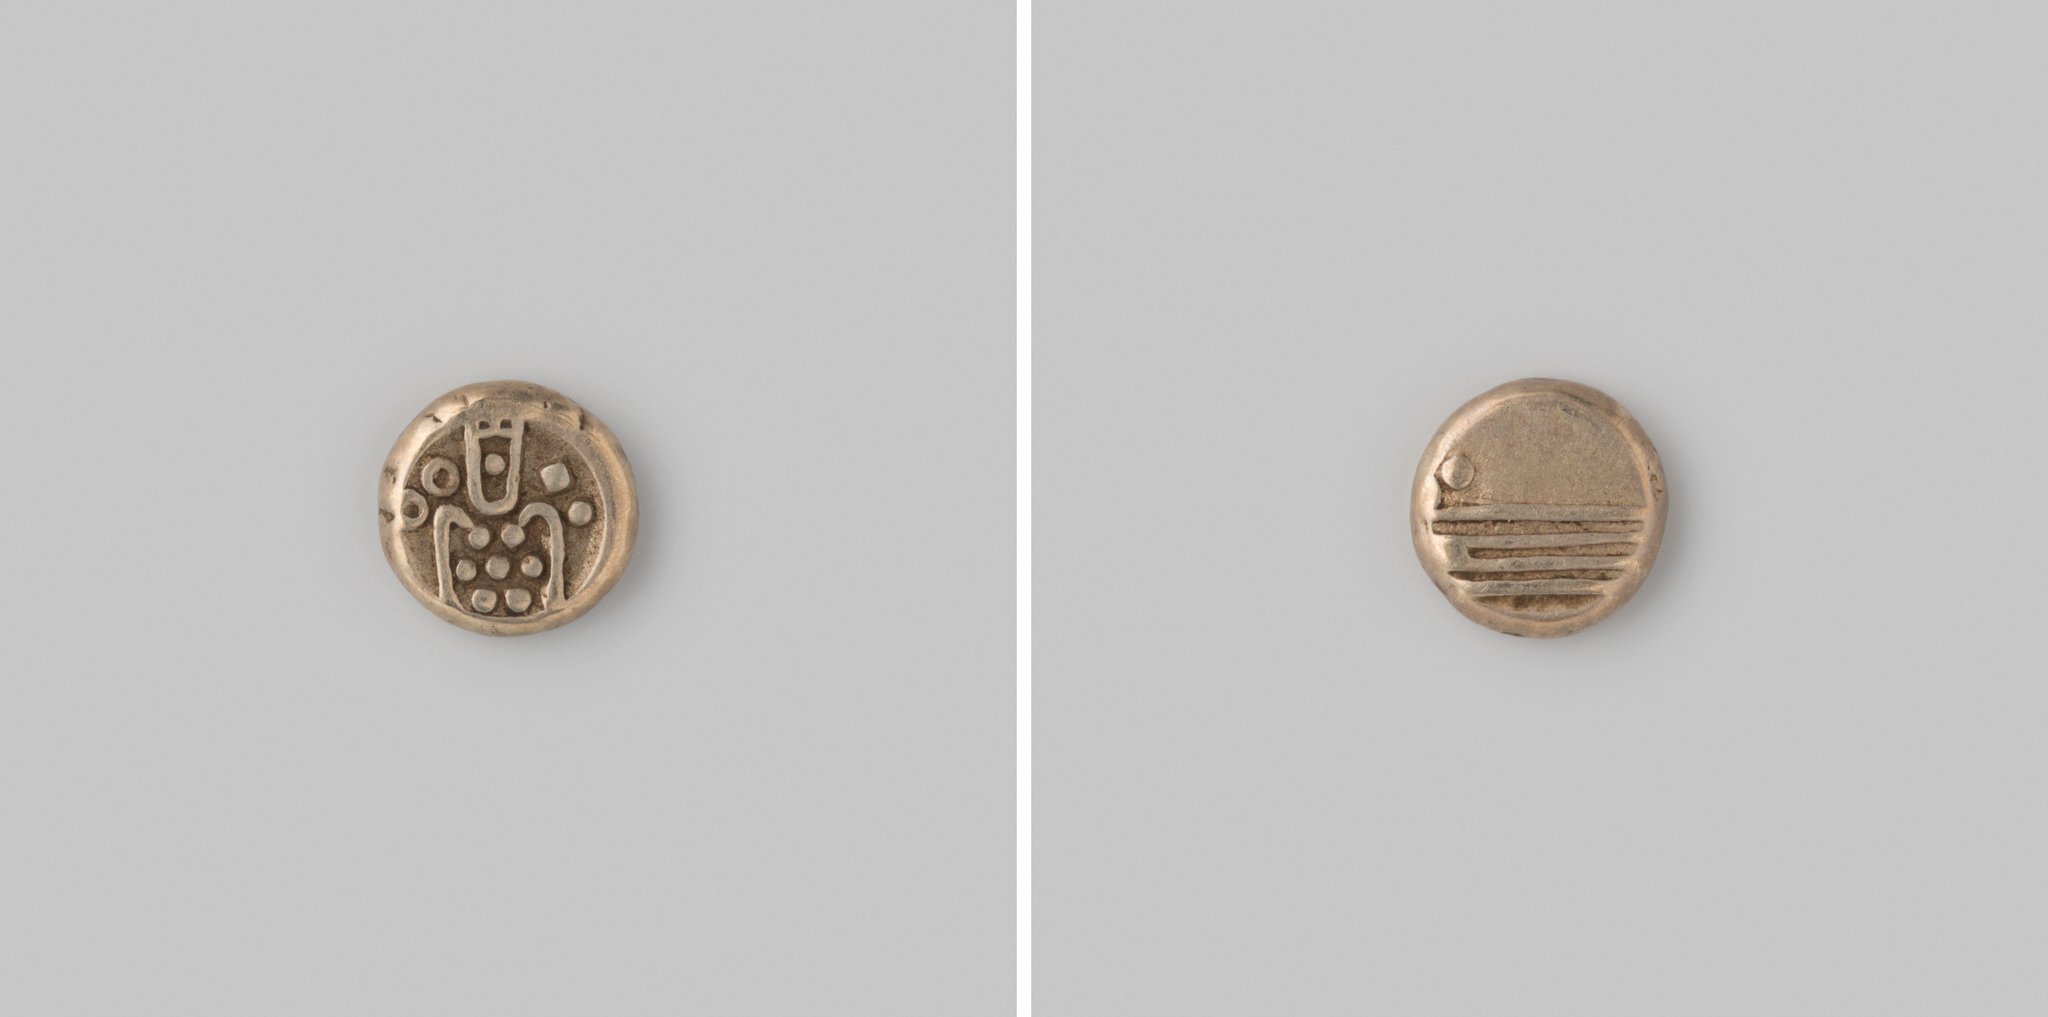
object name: coin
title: Fanam van de raja's van Coorg [?] in India,1687-1834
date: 1687-1834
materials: silver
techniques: striking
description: goud-zilveren munt. Voorzijde: vira raya-beeltenis. Keerzijde: ondetermineerbare lettertekens.